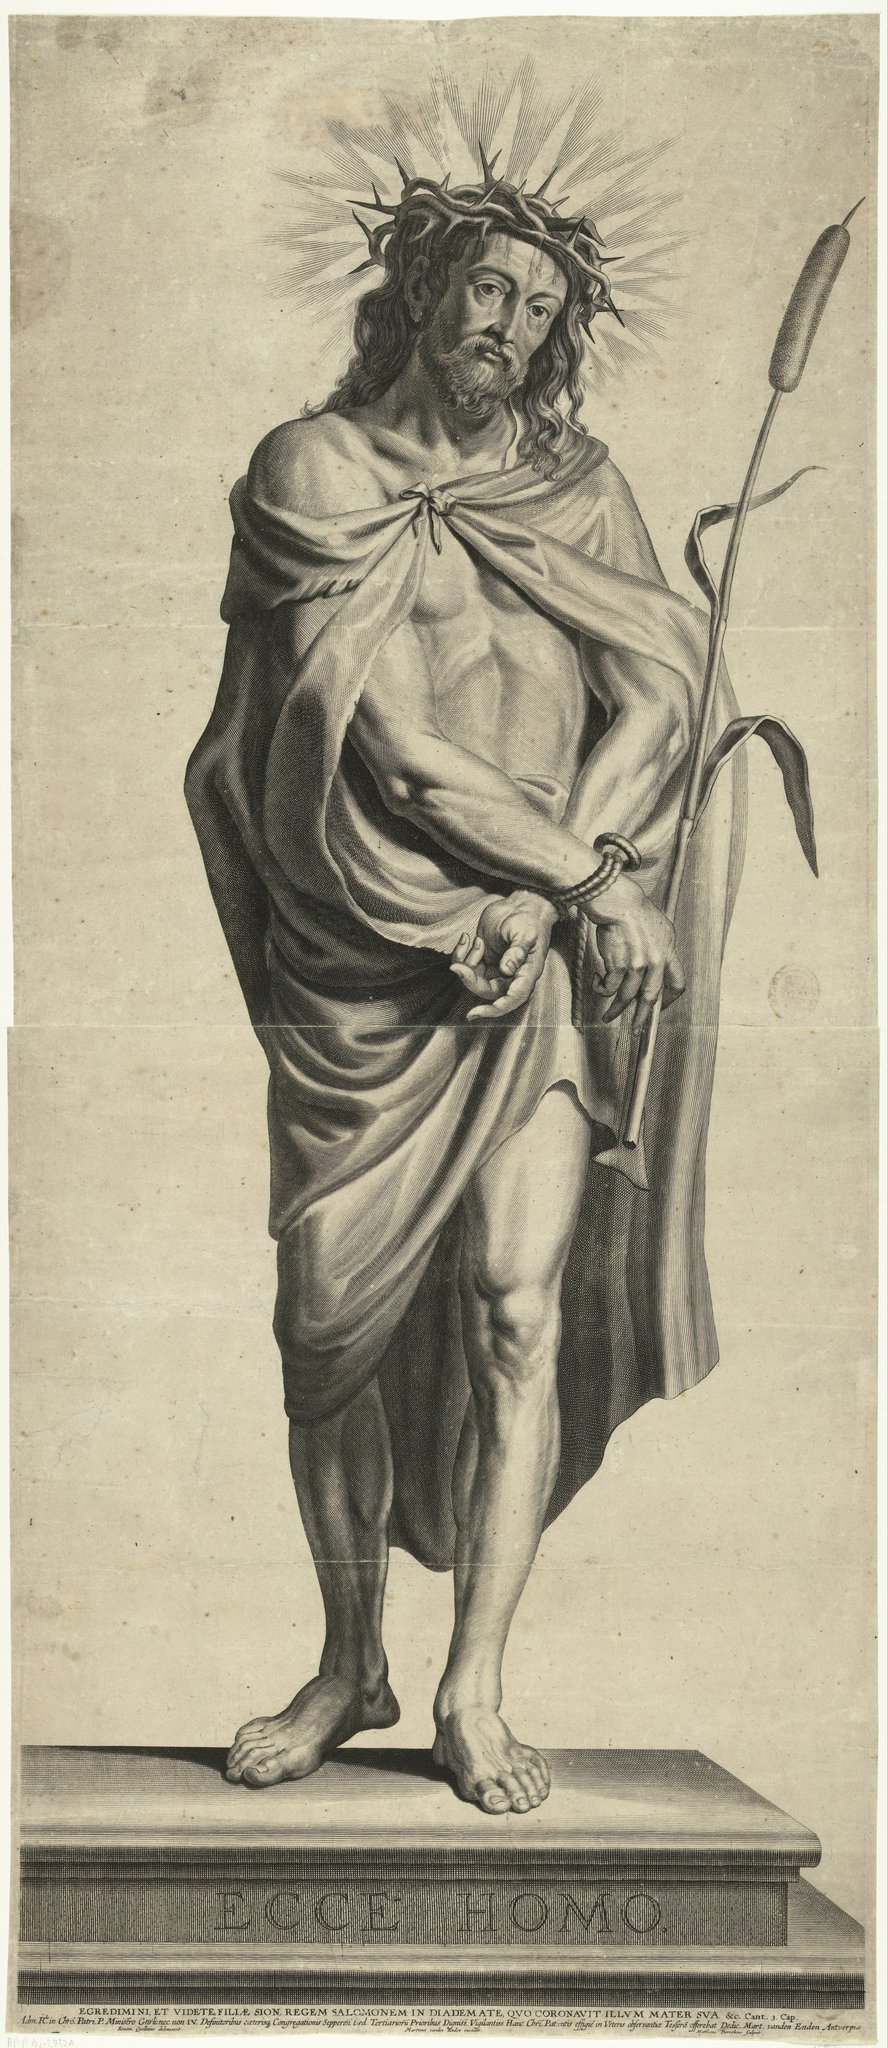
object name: print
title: Serie van Ecce Homo, de gekruisigde Christus, Maagd Maria en Johannes de Evangelist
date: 1625-1670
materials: paper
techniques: engraving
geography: antwerp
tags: christ alone (also called 'ecce homo')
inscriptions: collector's mark: Lugt 240 of 1838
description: Op de voorgrond van de prent staat de 'Ecce Homo', de gegeselde en met een doornenkroon gekroonde Christus. Christus staat op een verhoog waarop Ecce Homo staat geschreven. Hij draagt een gewaad en zijn handen zijn vastgebonden. In zijn rechterhand houdt hij een rietstengel vast als scepter. Hij huilt. De prent heeft een Latijns onderschrift.